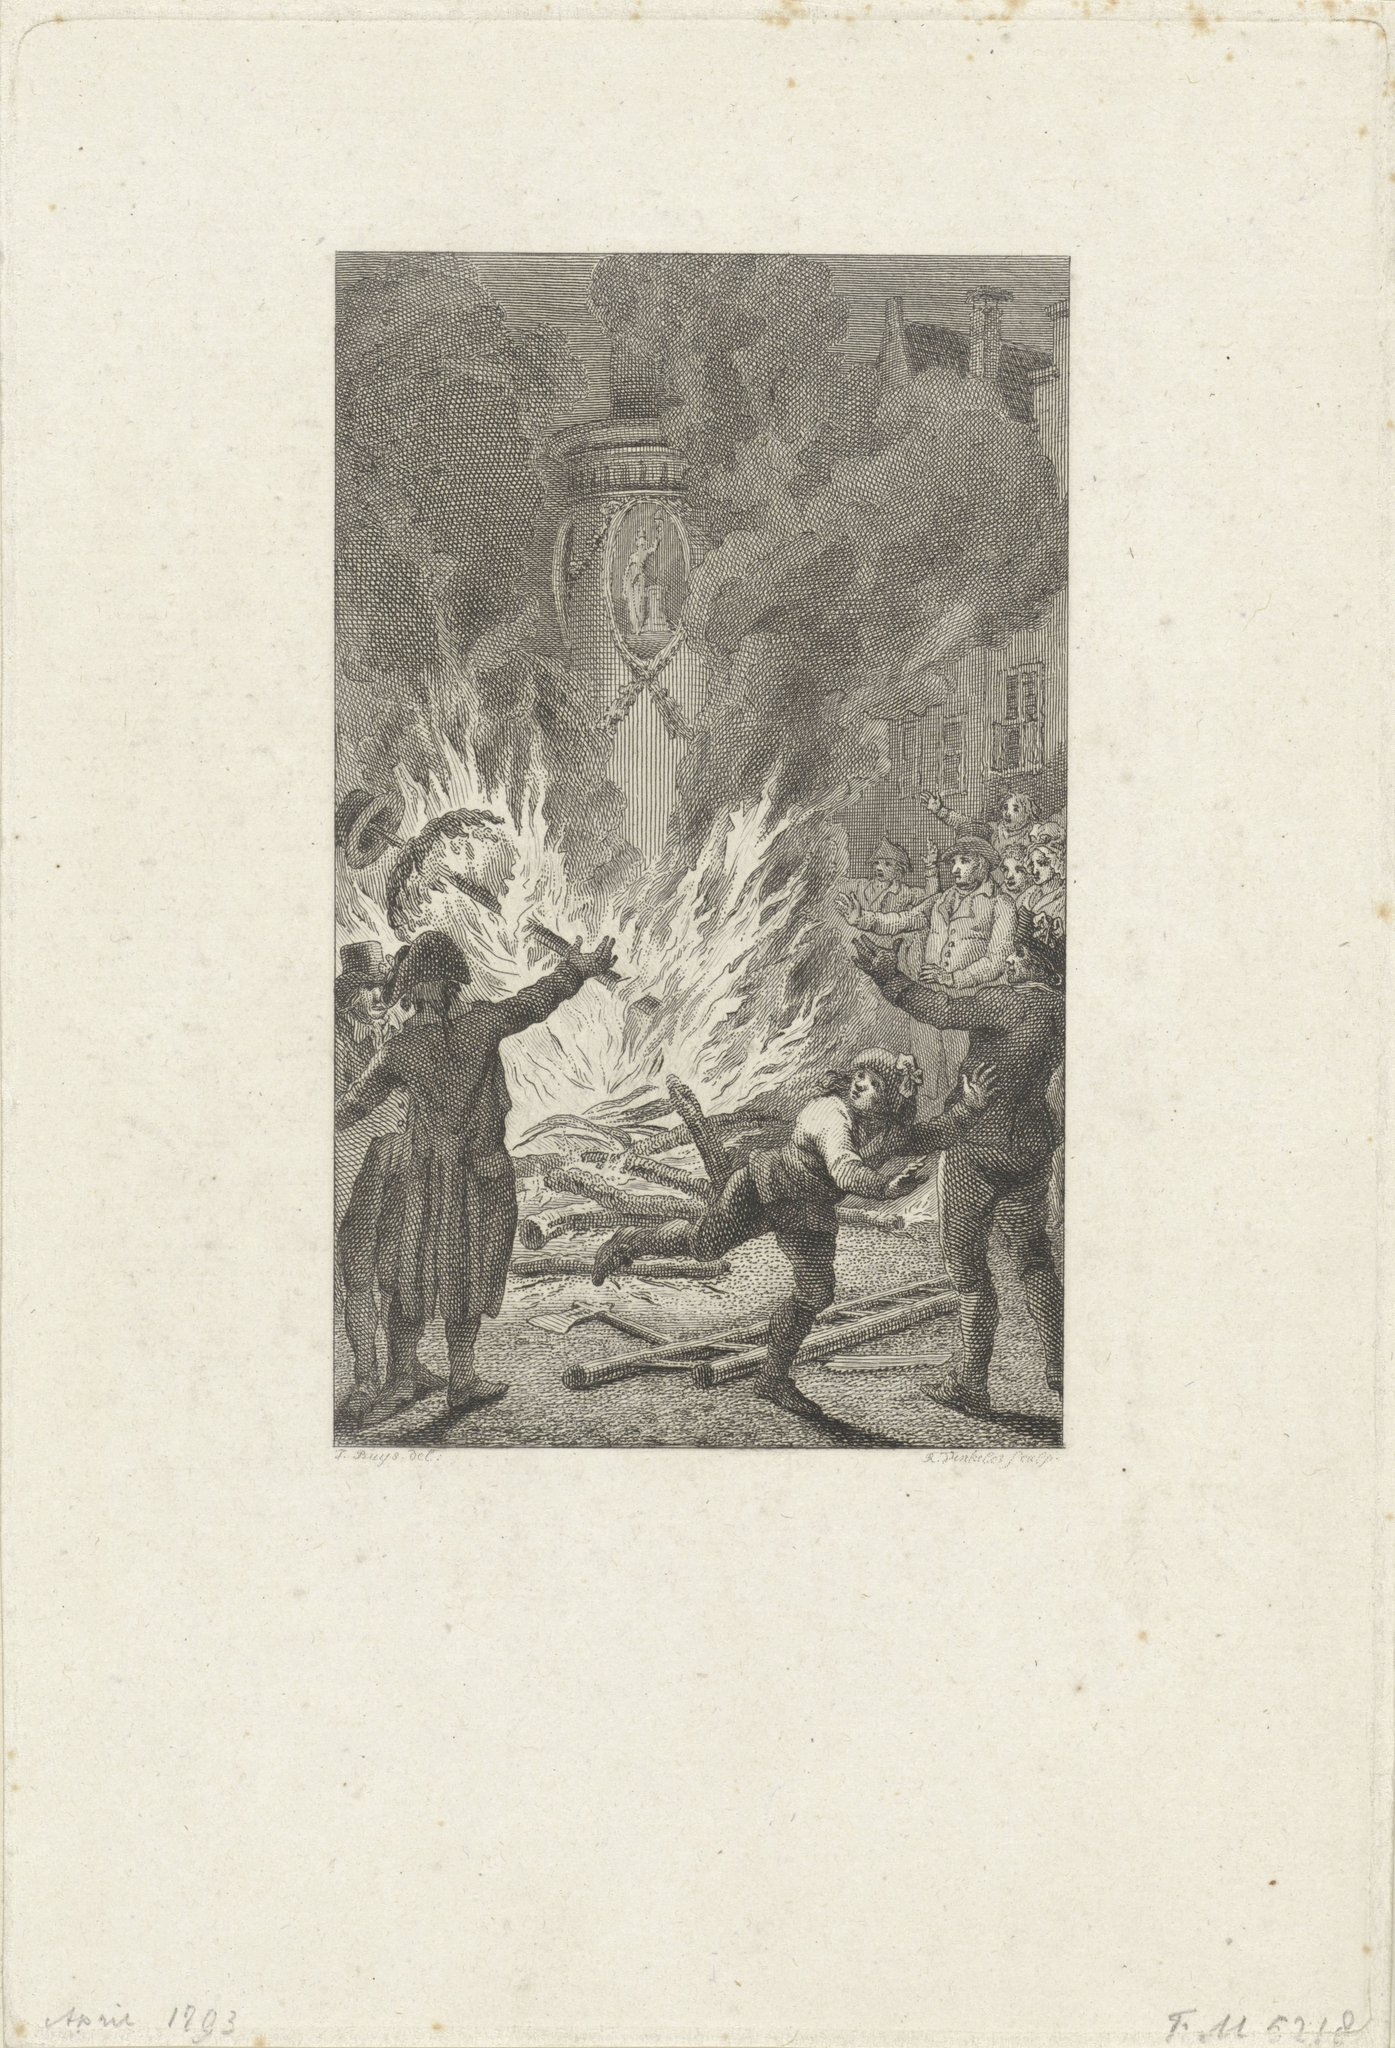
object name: print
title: Verbranden van de Vrijheidsboom te Breda 1793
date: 1801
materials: paper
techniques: engraving, etching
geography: amsterdam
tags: on fire, ablaze, dancing around the tree of liberty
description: Gebruikt als illustratie in: P.A. Loosjes. Vaderlandsche historie, vervattende de geschiedenissen, der Vereenigde Nederlanden (...). Ten onmiddelyken vervolge van Wagenaar's Vaderlandsche historie. Amsterdam: Johannes Allart, dl. 26 (1801).